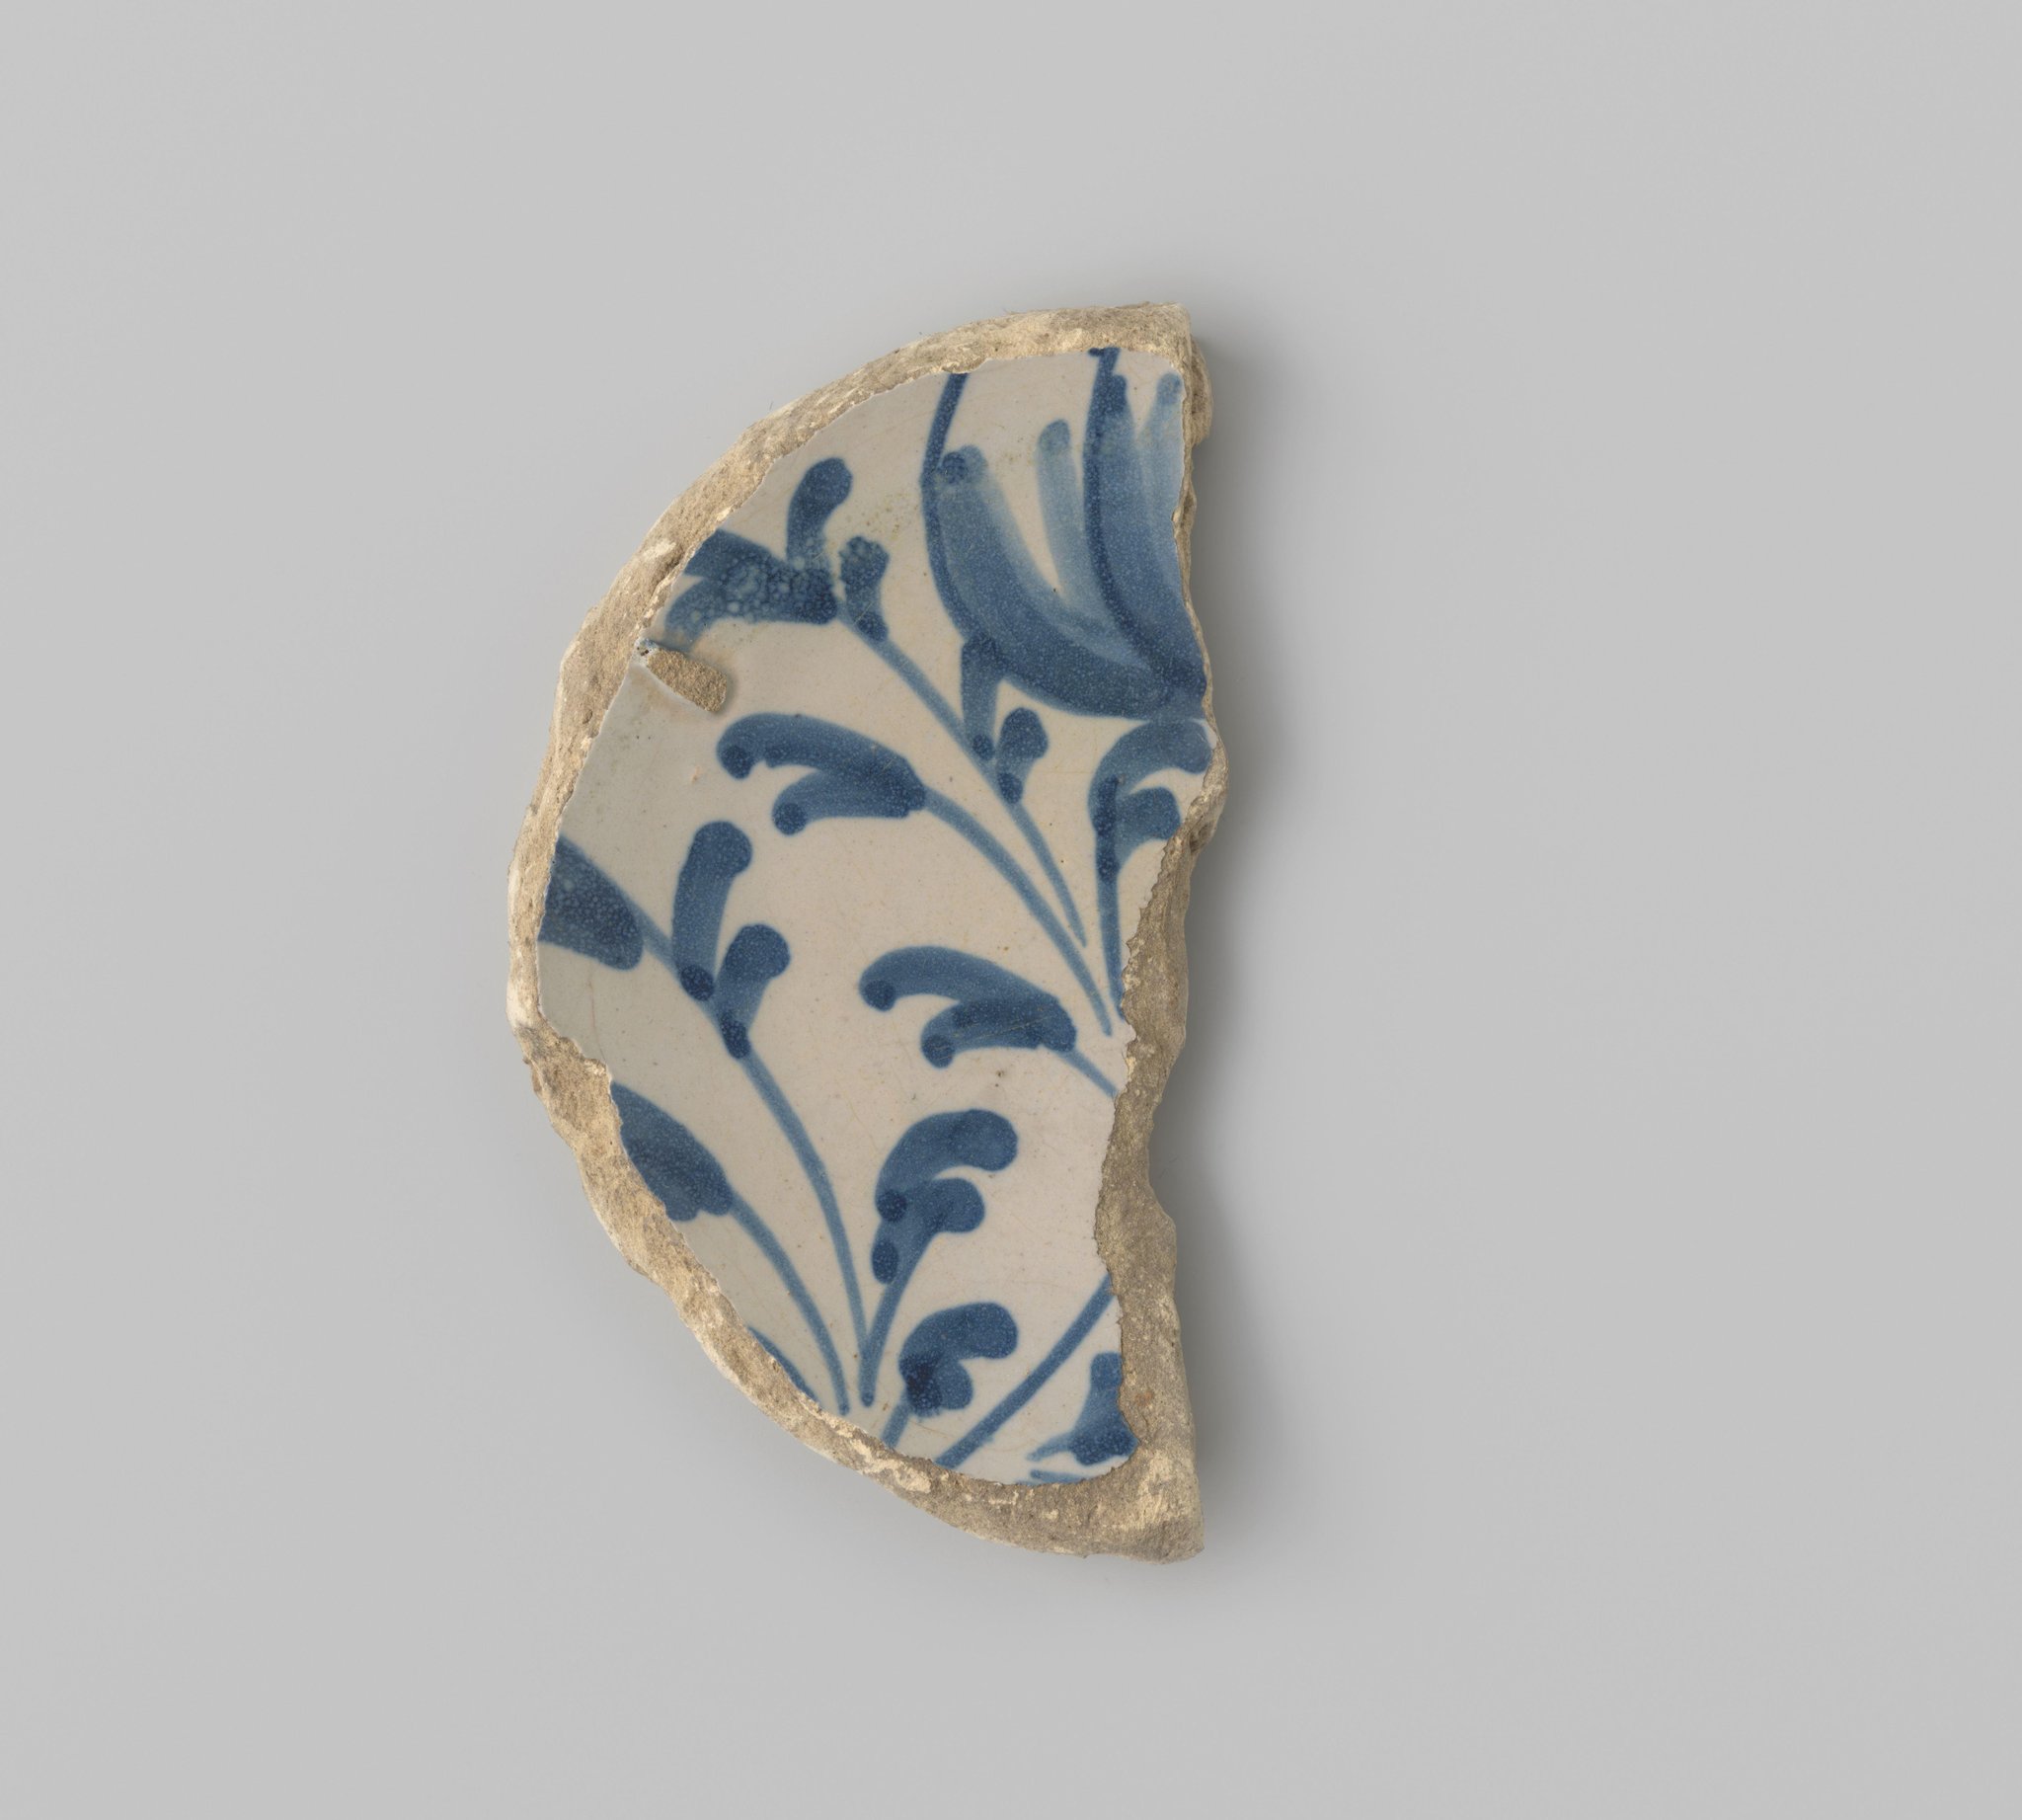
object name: sherd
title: Scherf van witbakkend aardewerk, met aan de voorzijde een decor van planten in blauw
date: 1500-1899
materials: earthenware, glaze